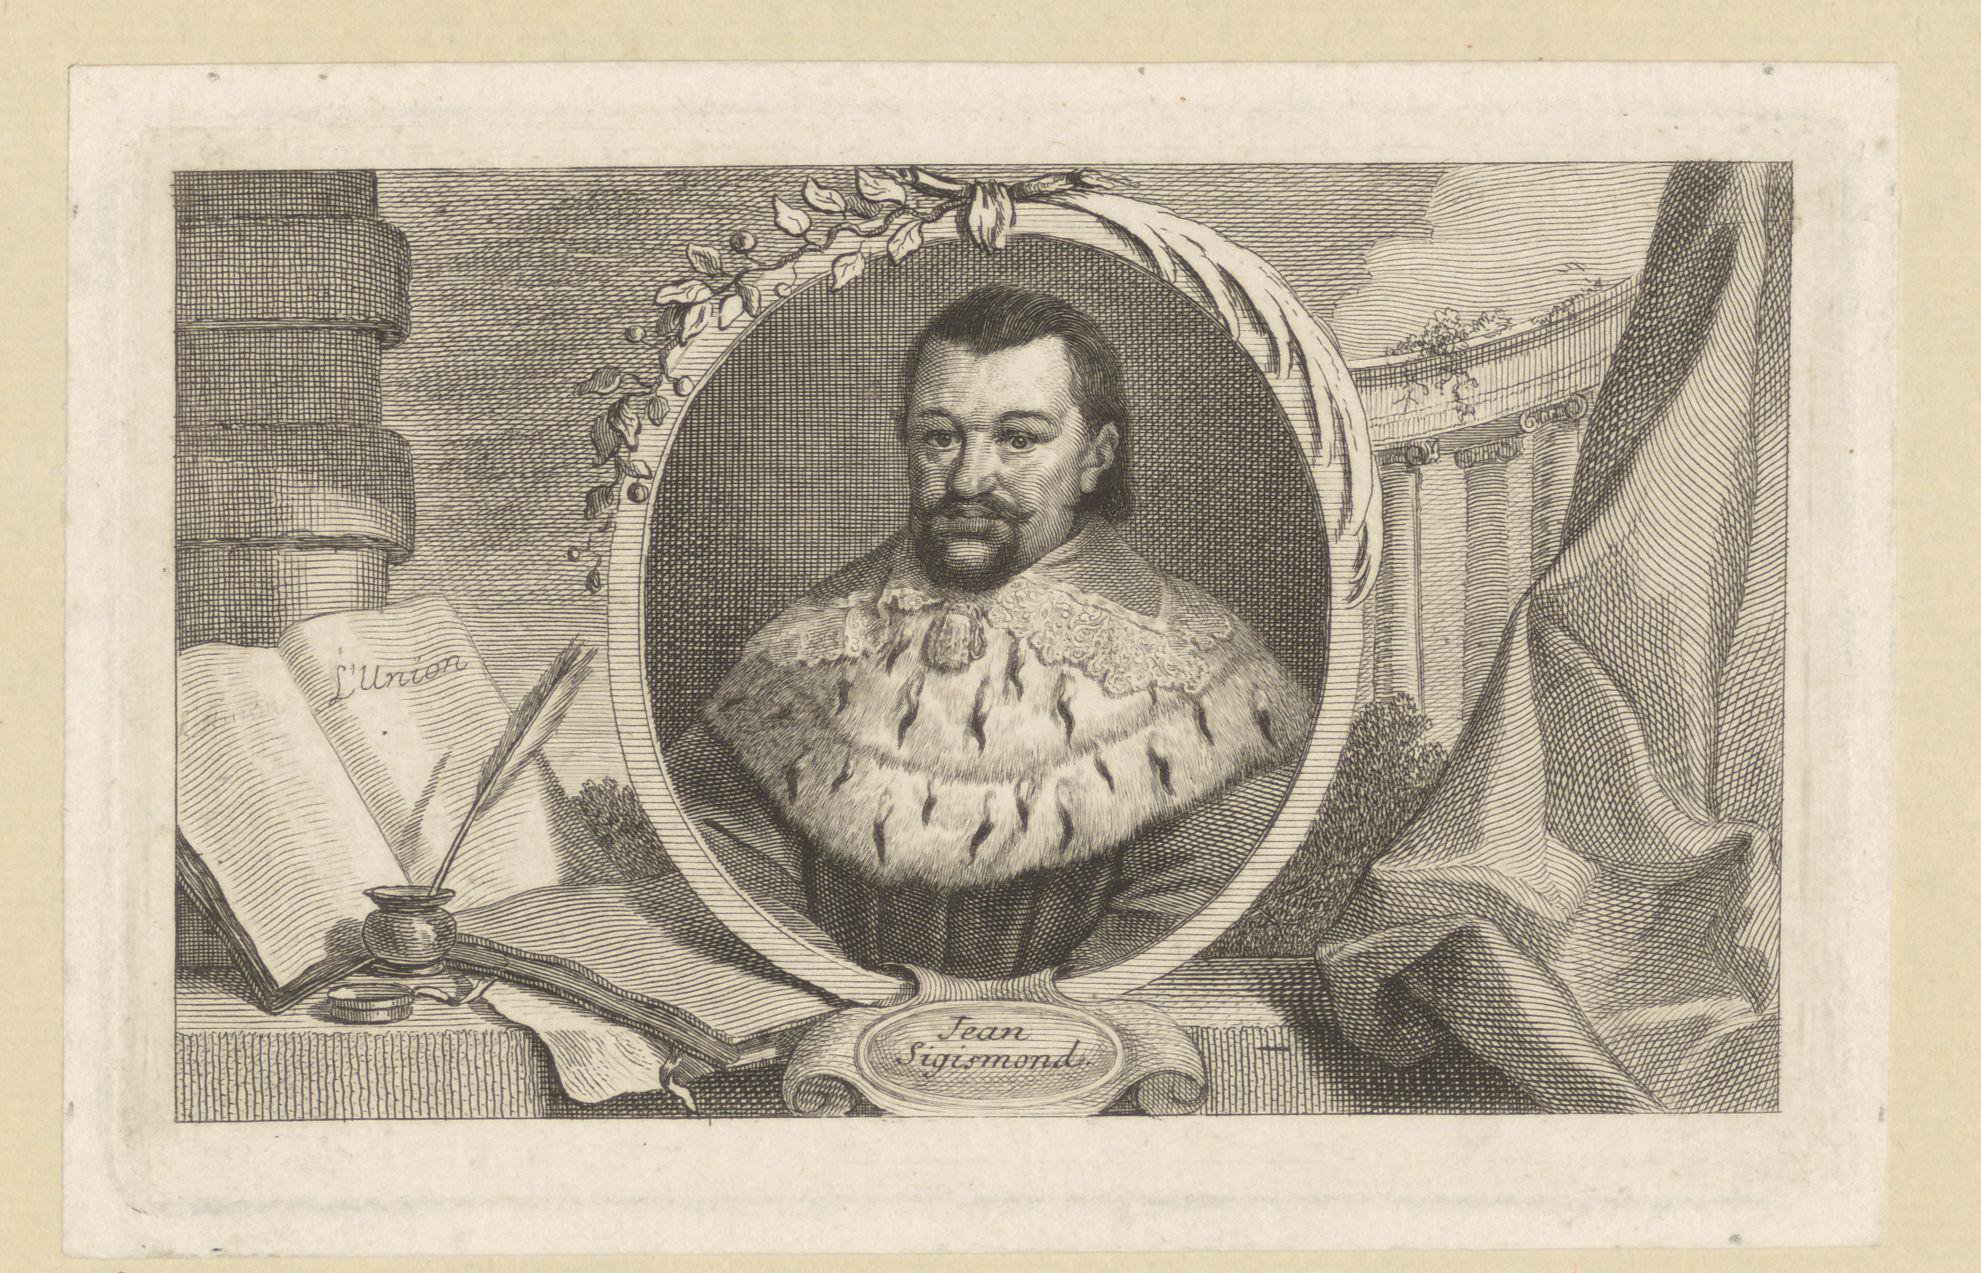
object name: print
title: Portret van Johann Sigismund, keurvorst van Brandenburg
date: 1751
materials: paper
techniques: engraving, etching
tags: historical persons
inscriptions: collector's mark: Lugt 240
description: Prent ook gebruikt in: Frederik de Grote. Mémoires pour servir a l'histoire de la maison de Brandebourg. Sanssouci, Frederik de Grote, 1751.